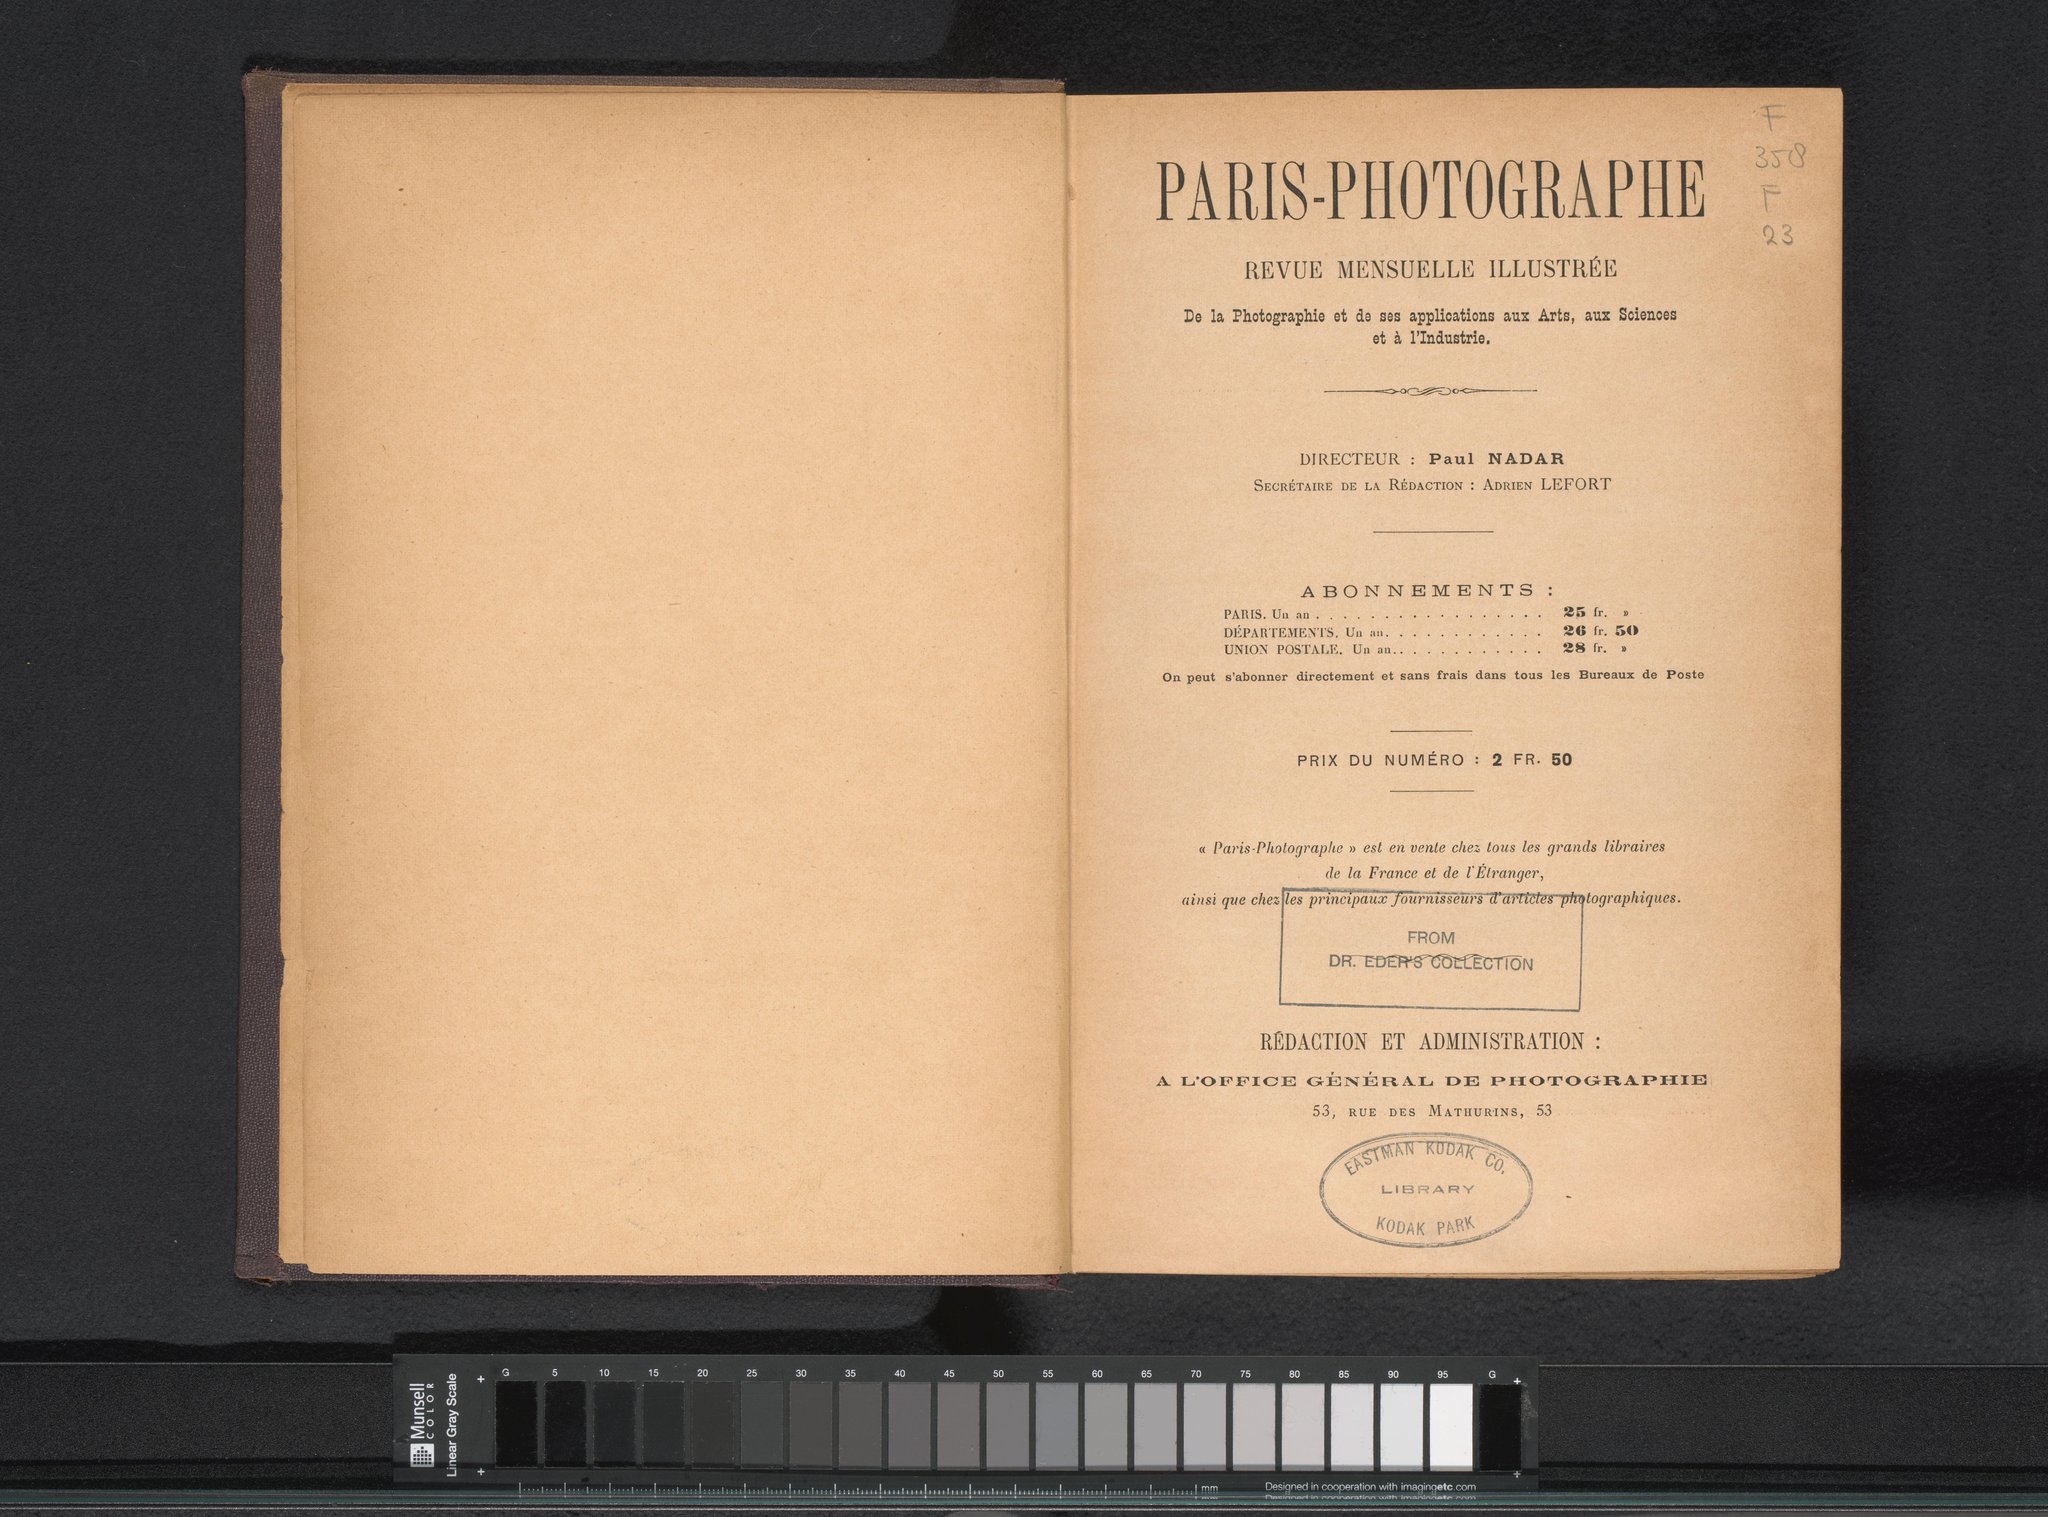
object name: magazine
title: Paris-Photographe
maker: paul nadar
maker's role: fotograaf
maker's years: 1856-1939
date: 1893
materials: cardboard, linen, paper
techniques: photograph, photoaquatint, printing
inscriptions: number: ‘Accession No. 6578’, name: ‘Eastman Kodak Co. Library Kodak Park’, name: ‘From DR. Eder's Collection’